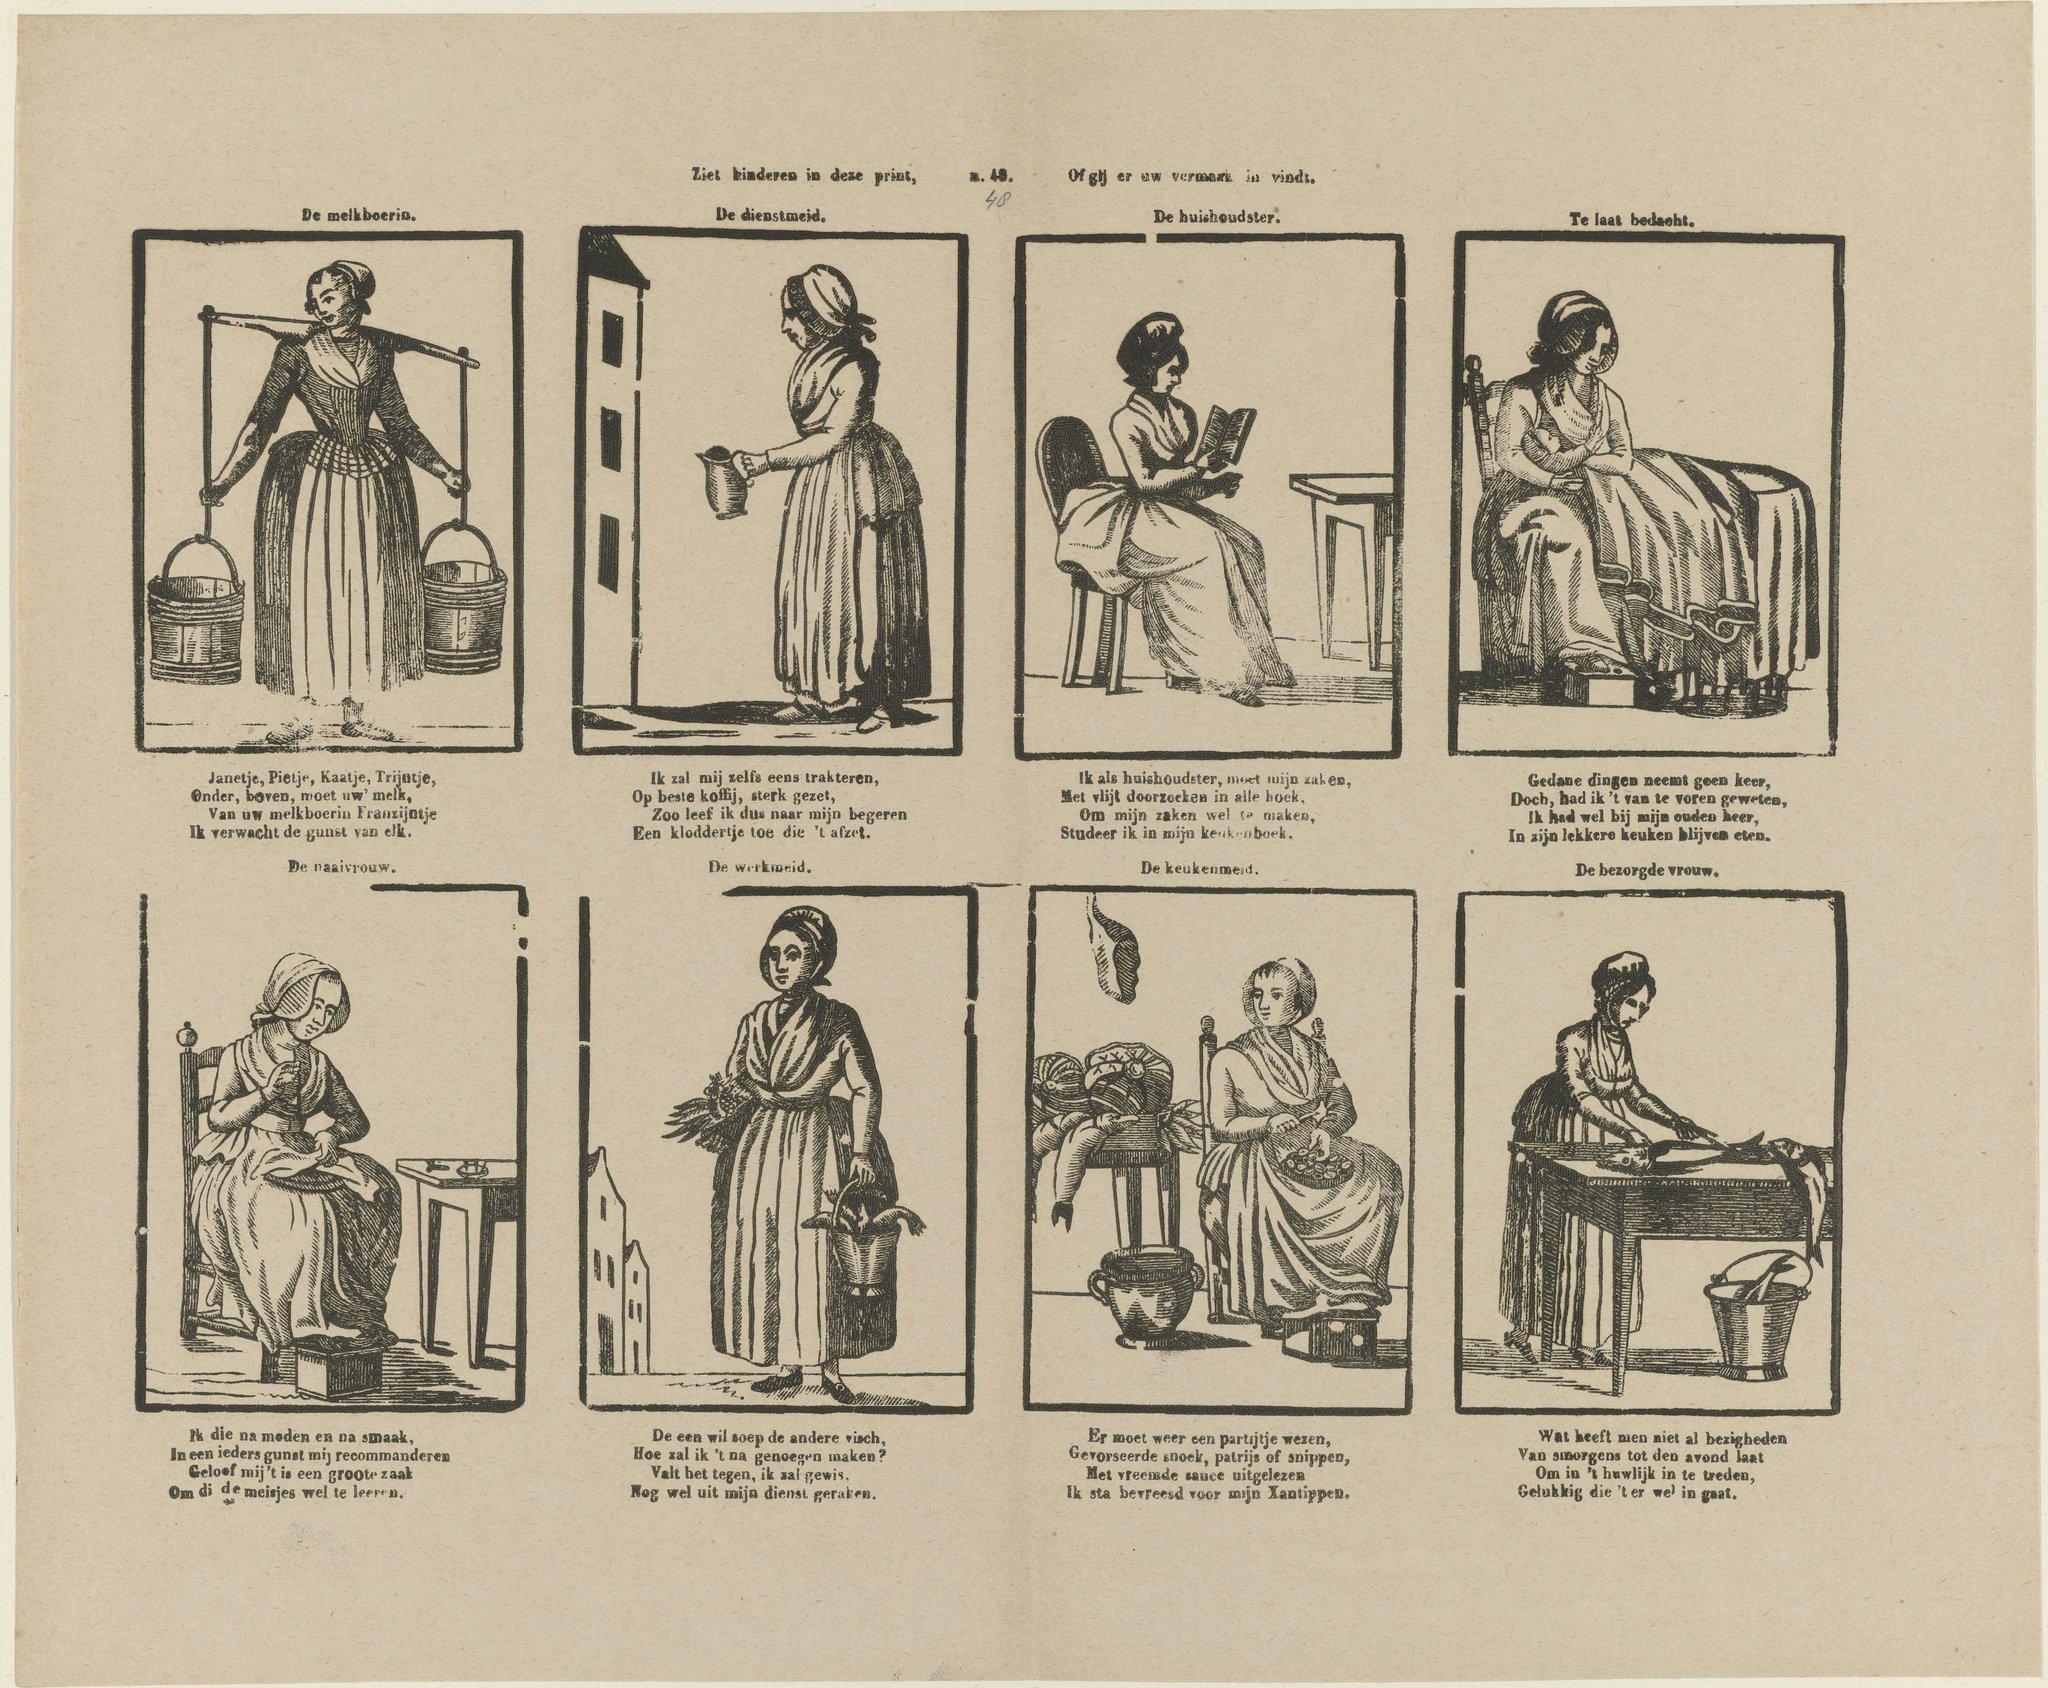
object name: popular print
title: Ziet kinderen in deze print, of gij er uw vermaak in vindt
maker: Anonymous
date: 1856-1900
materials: paper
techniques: letterpress printing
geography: turnhout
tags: embroidering ~ textile industry, reading, cooking food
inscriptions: collector's mark: Lugt 2760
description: Blad met 8 voorstellingen van bezigheden voor vrouwen, bijvoorbeeld lezen en borduren. Boven elke afbeelding een titel, onder elke voorstelling een vierregelig vers. Genummerd midden boven: n. 48.